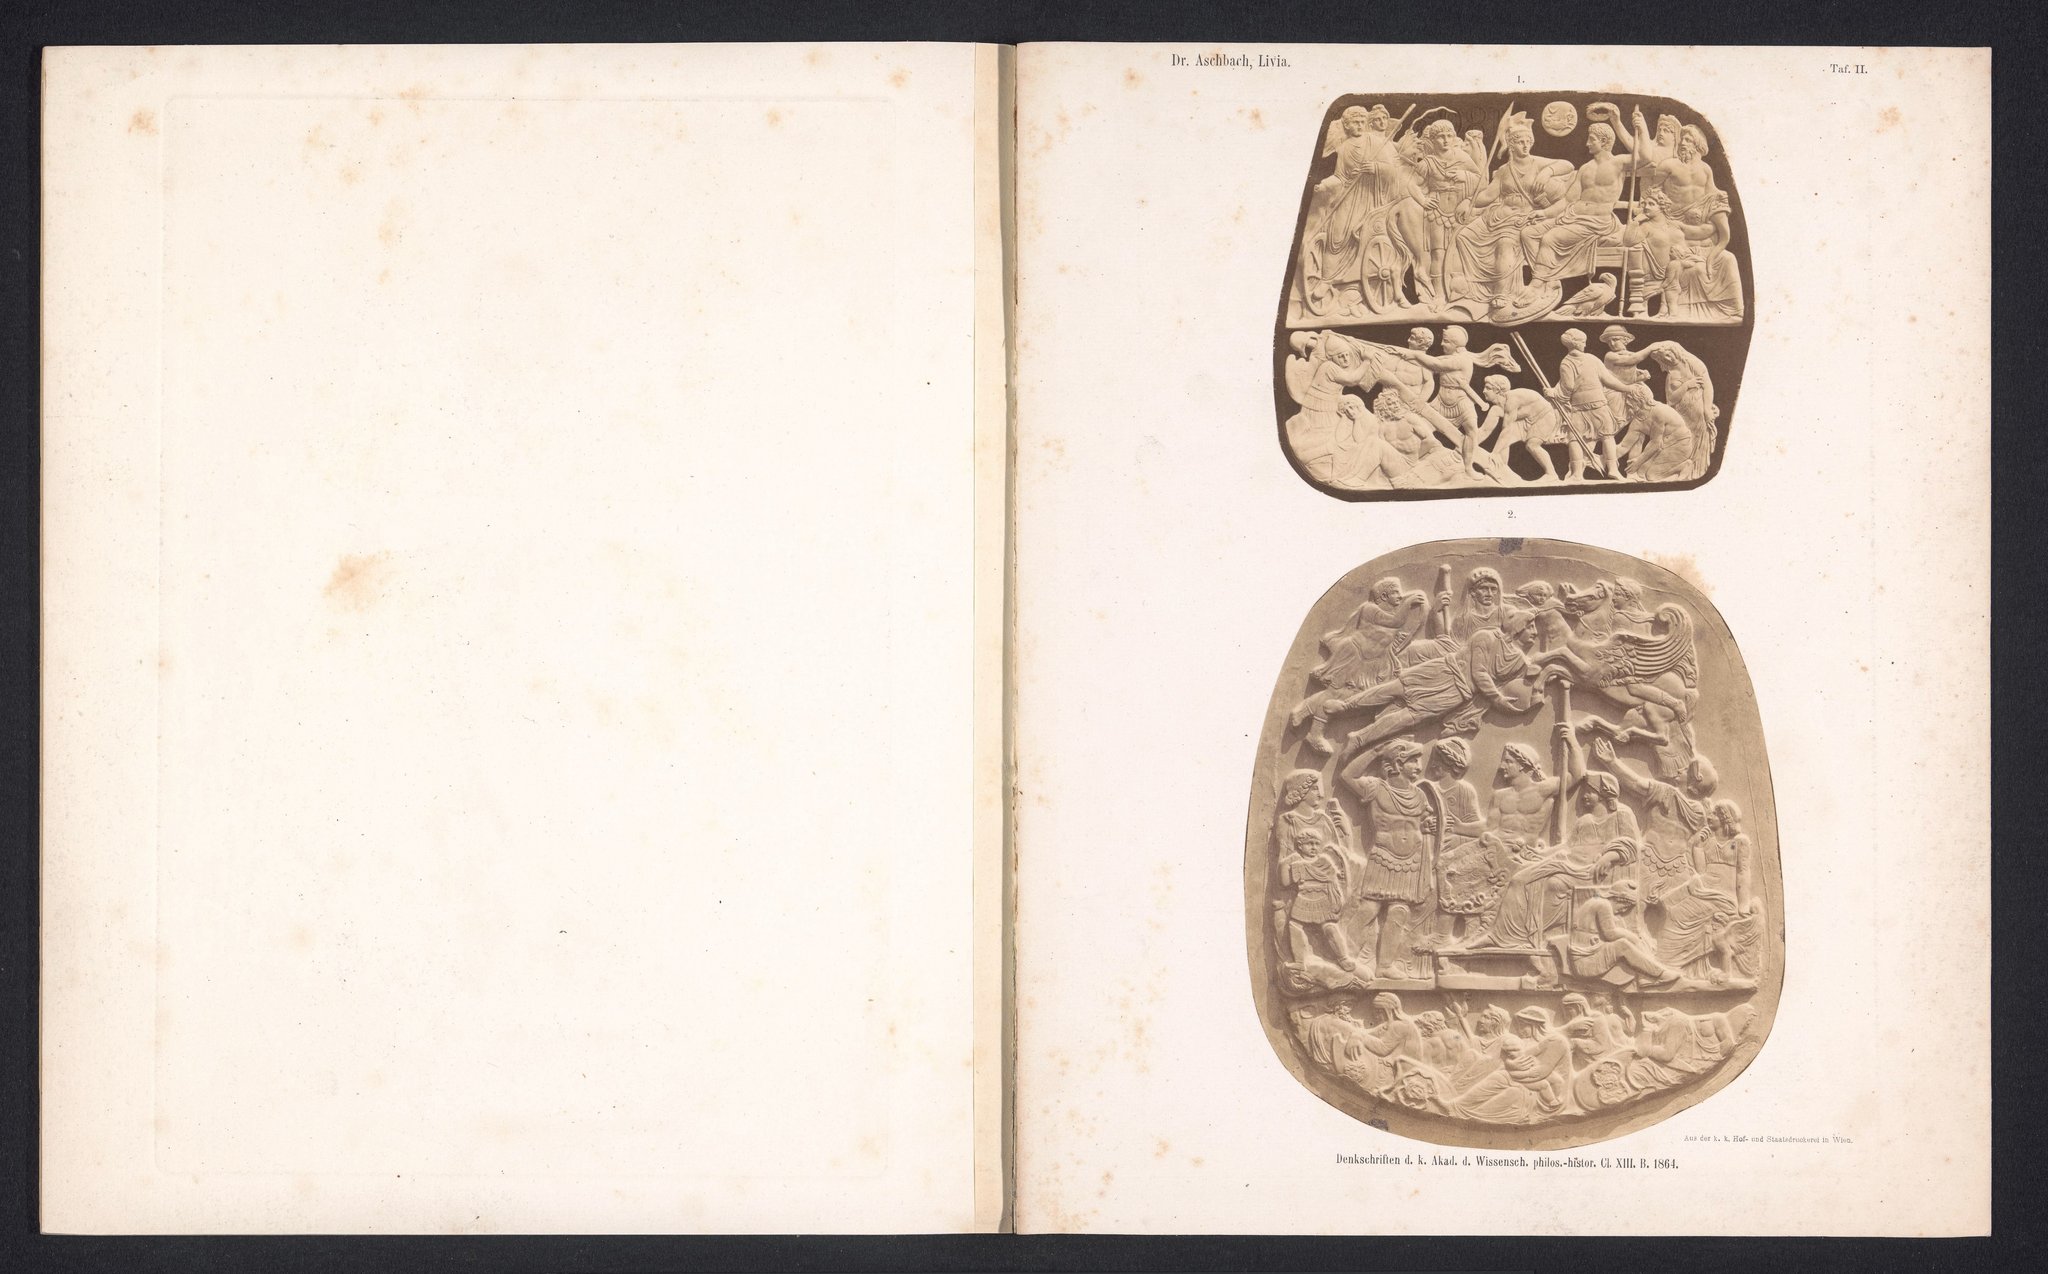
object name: page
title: Twee reliëfs gedecoreerd met gebeurtenissen uit het leven van Livia Drusilla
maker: Anonymous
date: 1854-1864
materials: photographic support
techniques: albumen print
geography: vienna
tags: rome, sculpture (+ relief ~ sculpture)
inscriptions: inscription: ‘Denkschriften d.k. Akad. d. Wissensch. philos.-histor. Cl. XIII. B. 1864.’, number: ‘Taf. II.’